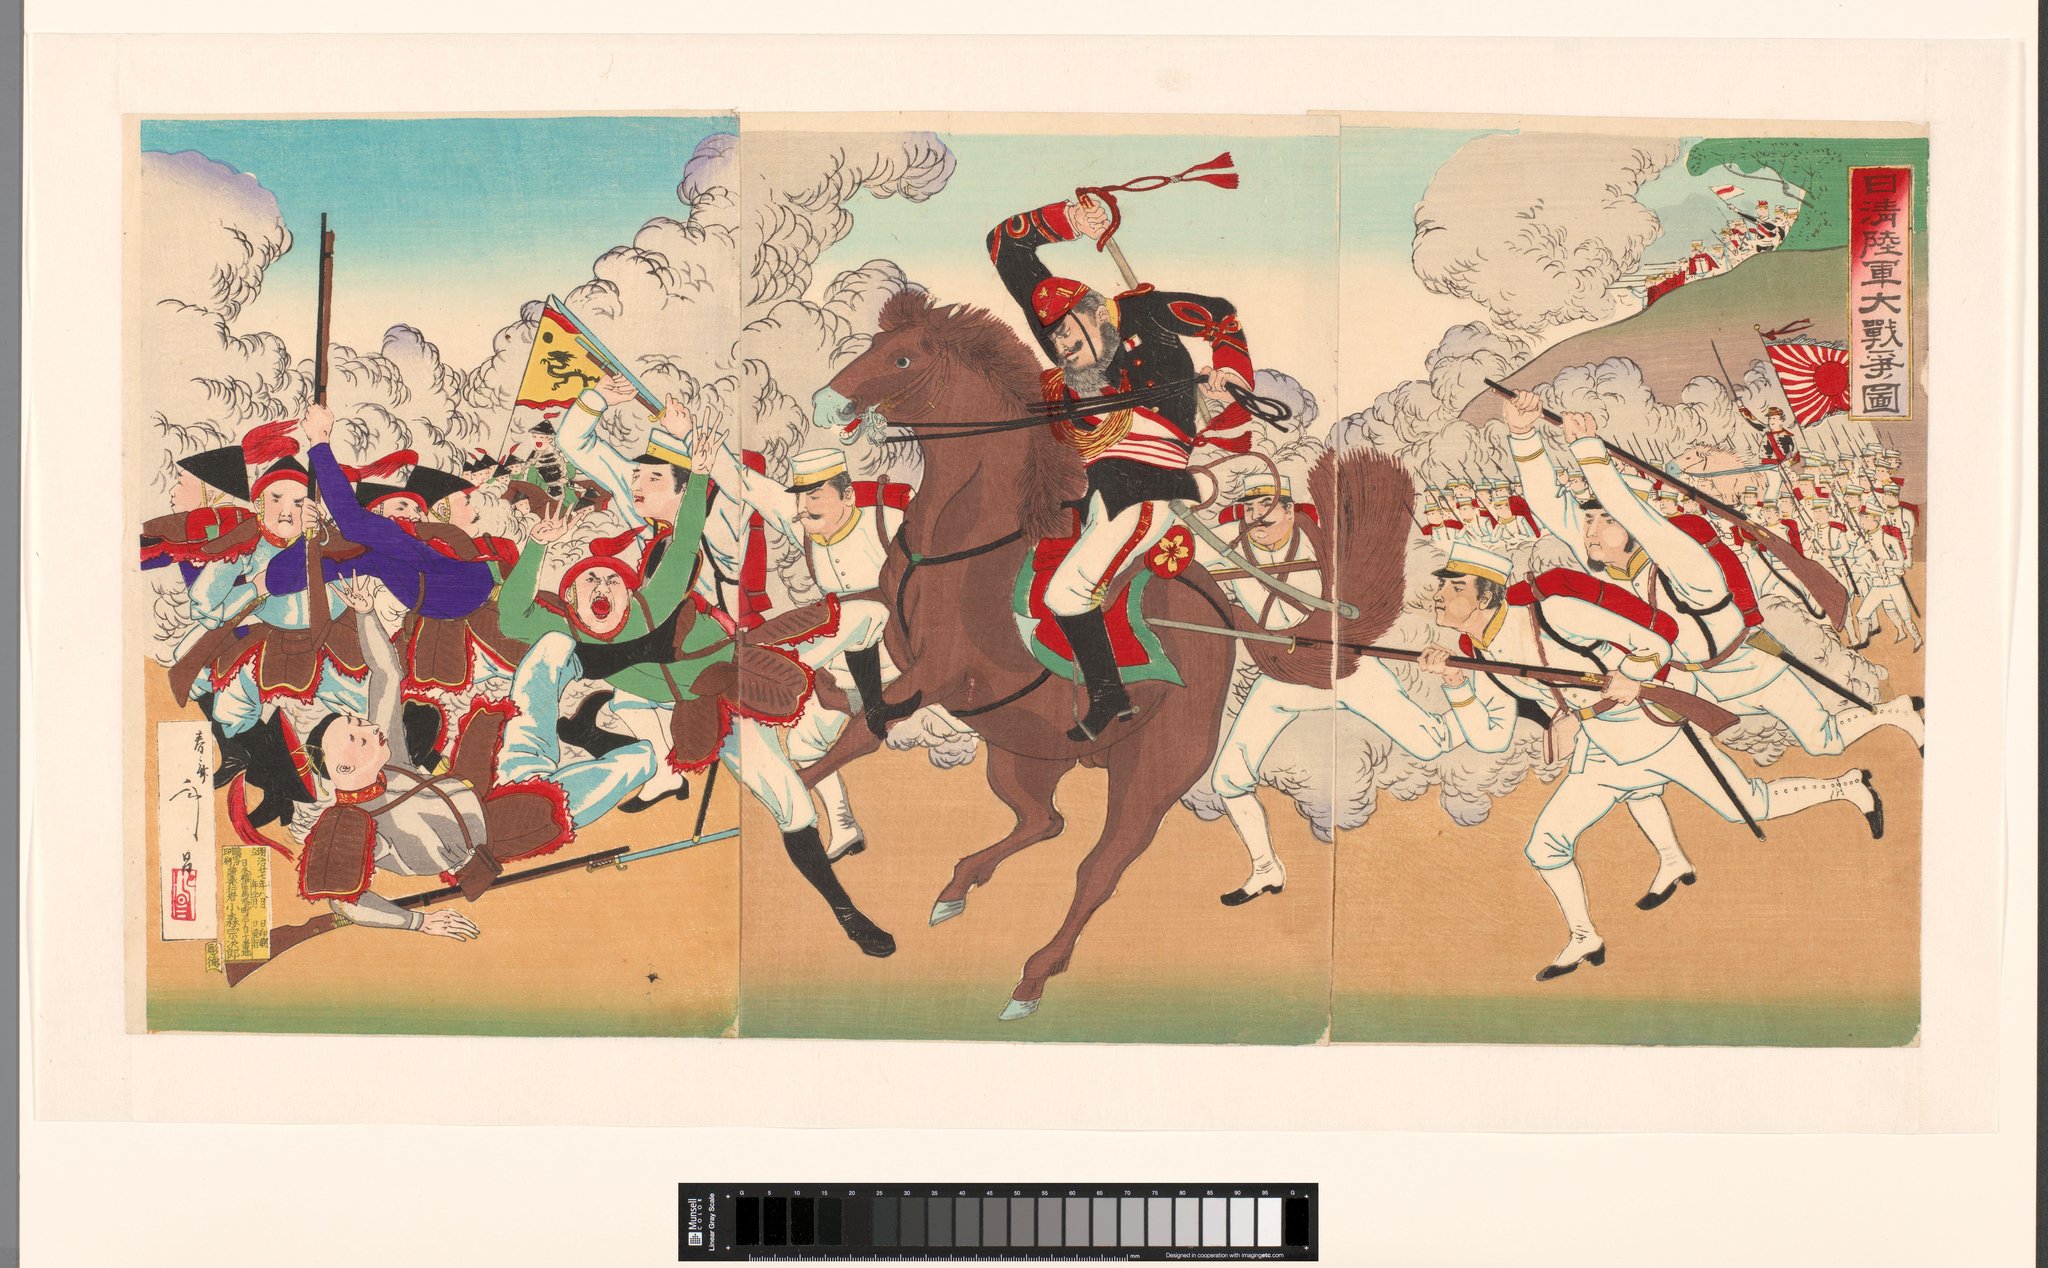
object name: print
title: Japanse oorlogsprent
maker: Anonymous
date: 1894-1905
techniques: woodcut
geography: japan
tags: war